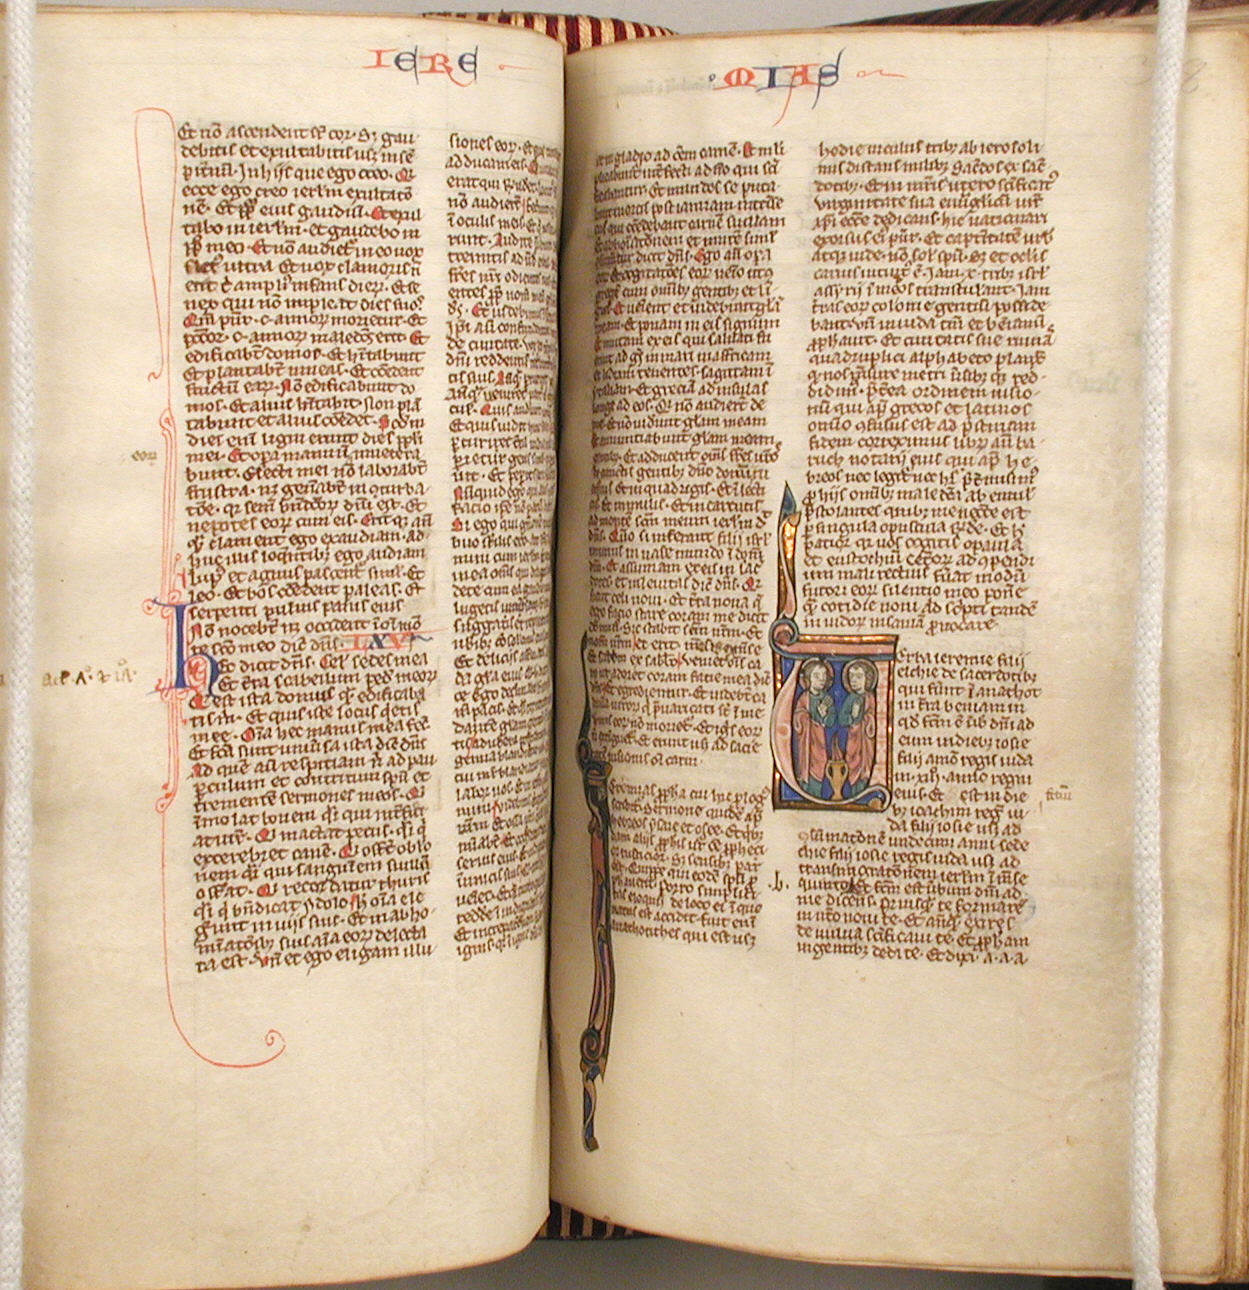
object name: bible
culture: french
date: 1235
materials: ink, leather, metal leaf, parchment, paint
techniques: bookbinding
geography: france